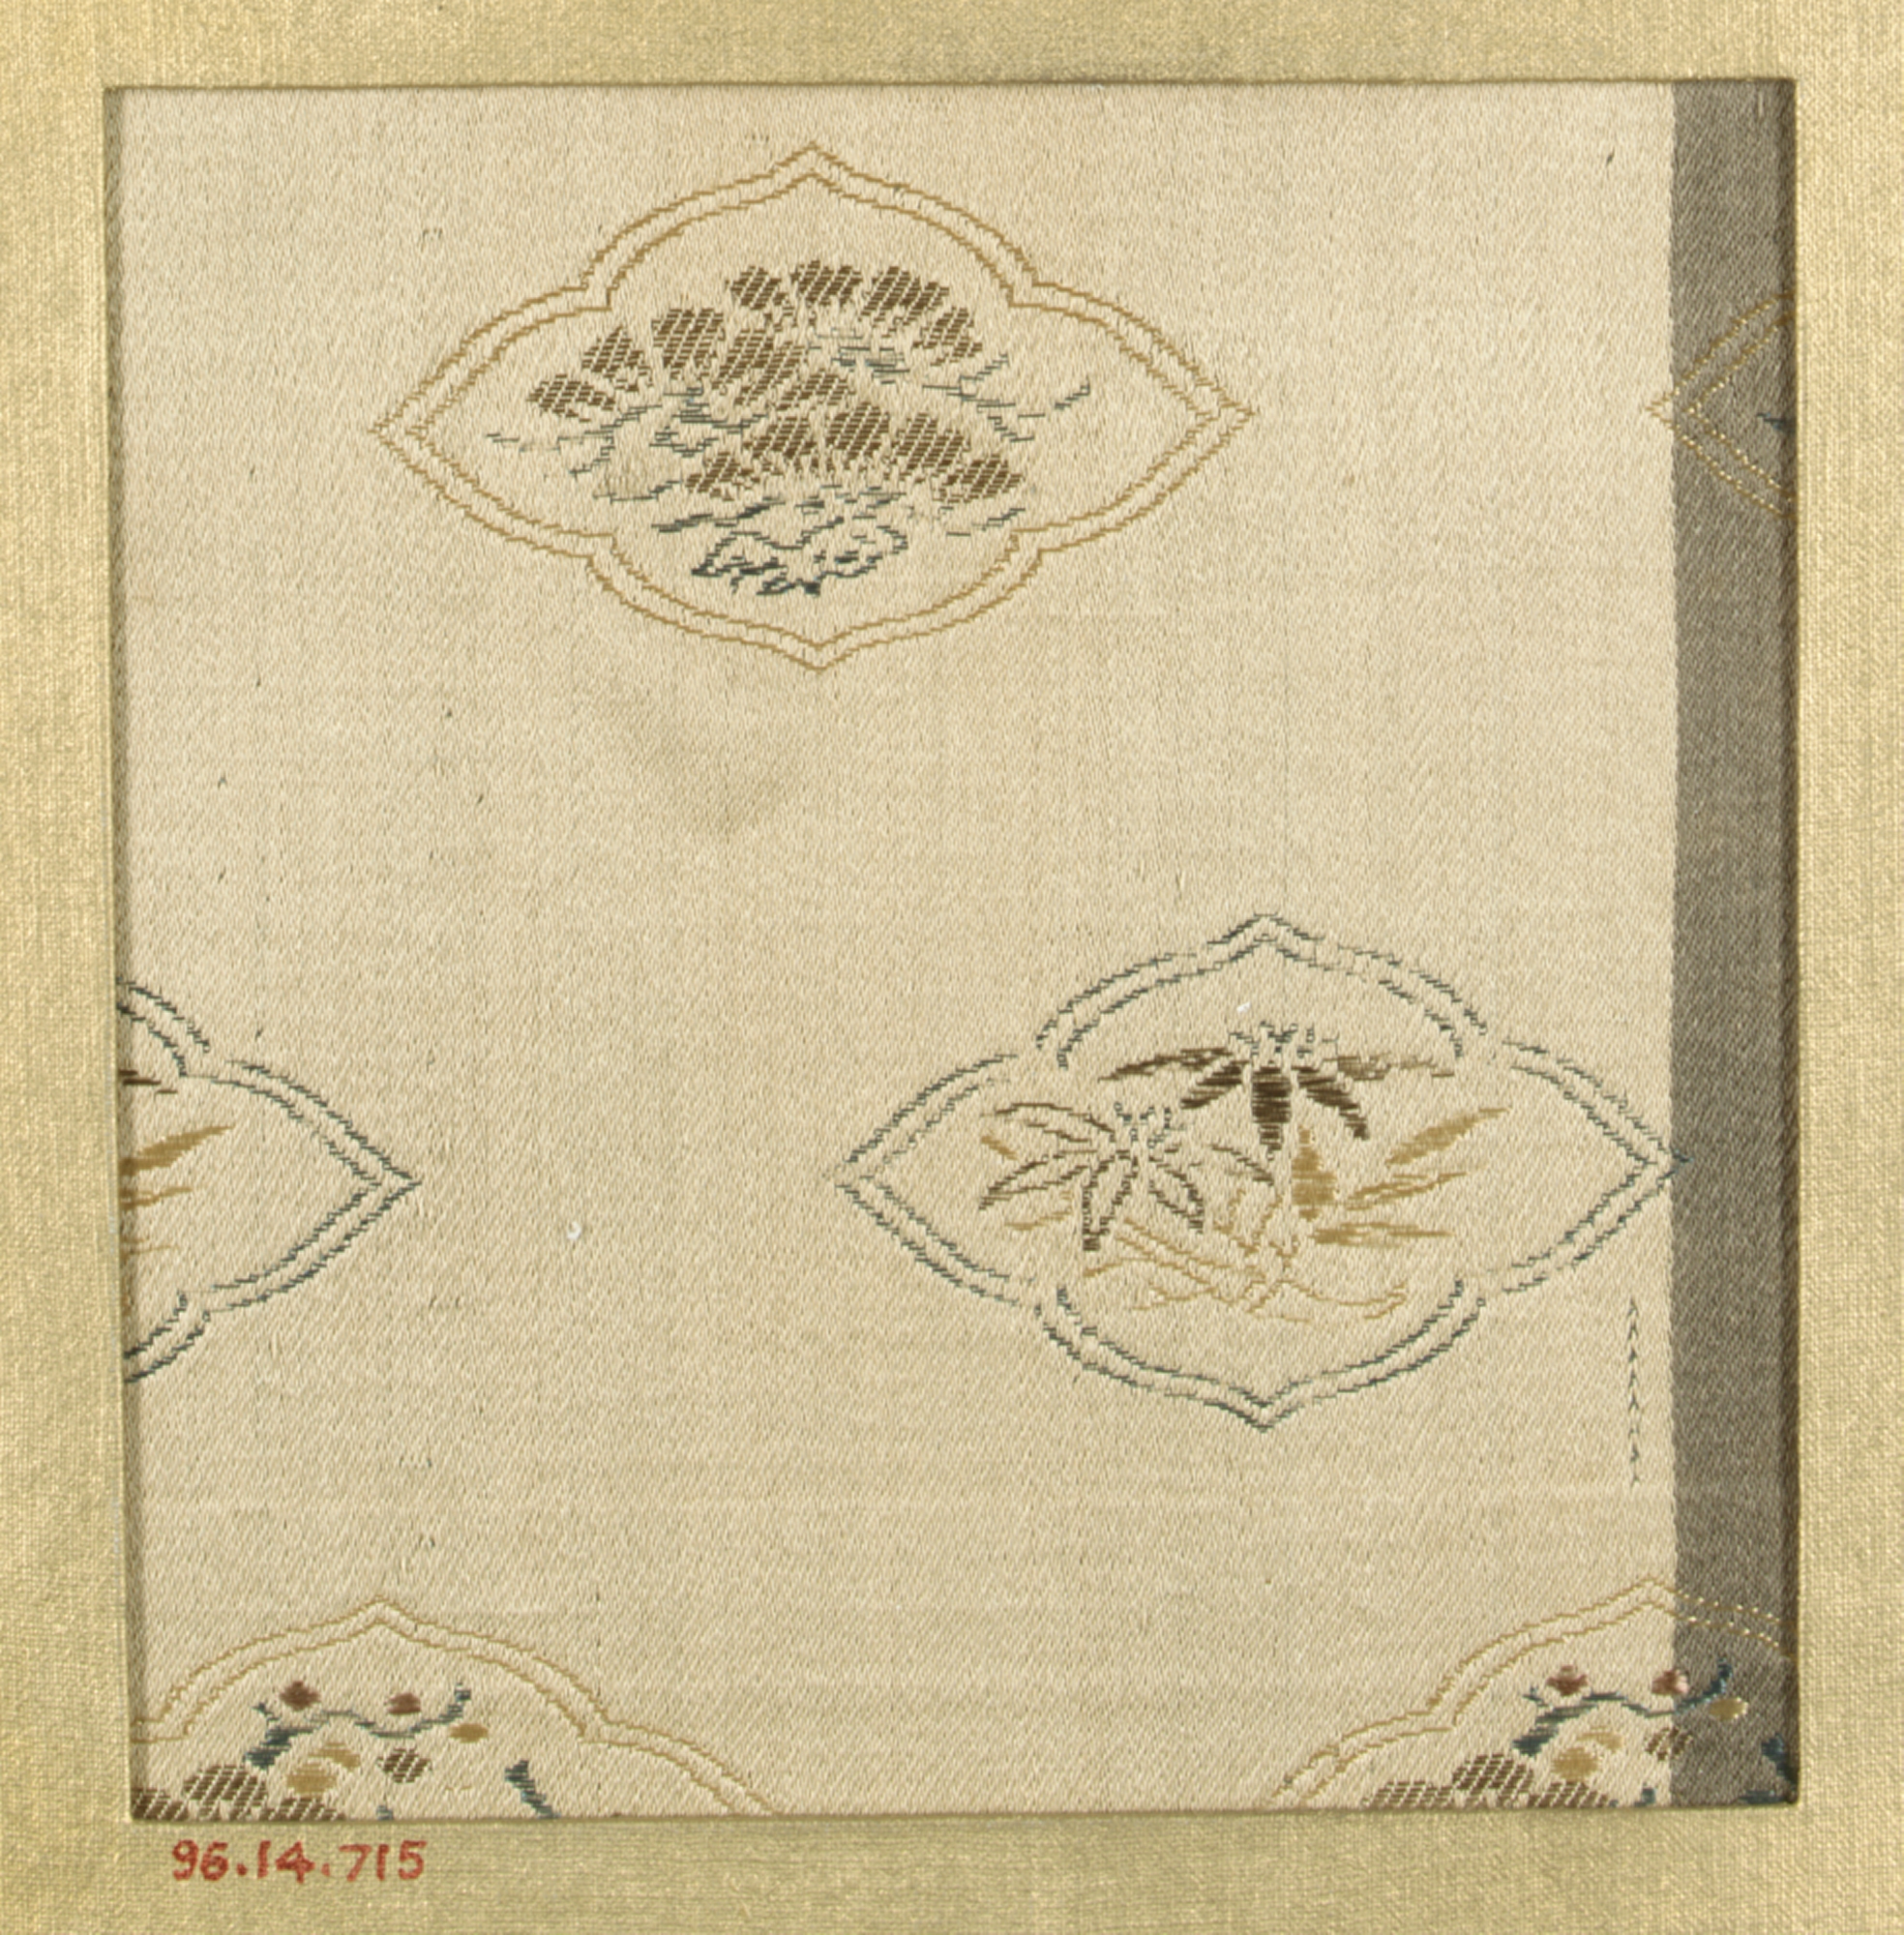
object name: piece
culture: japanese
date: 1701-1900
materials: silk